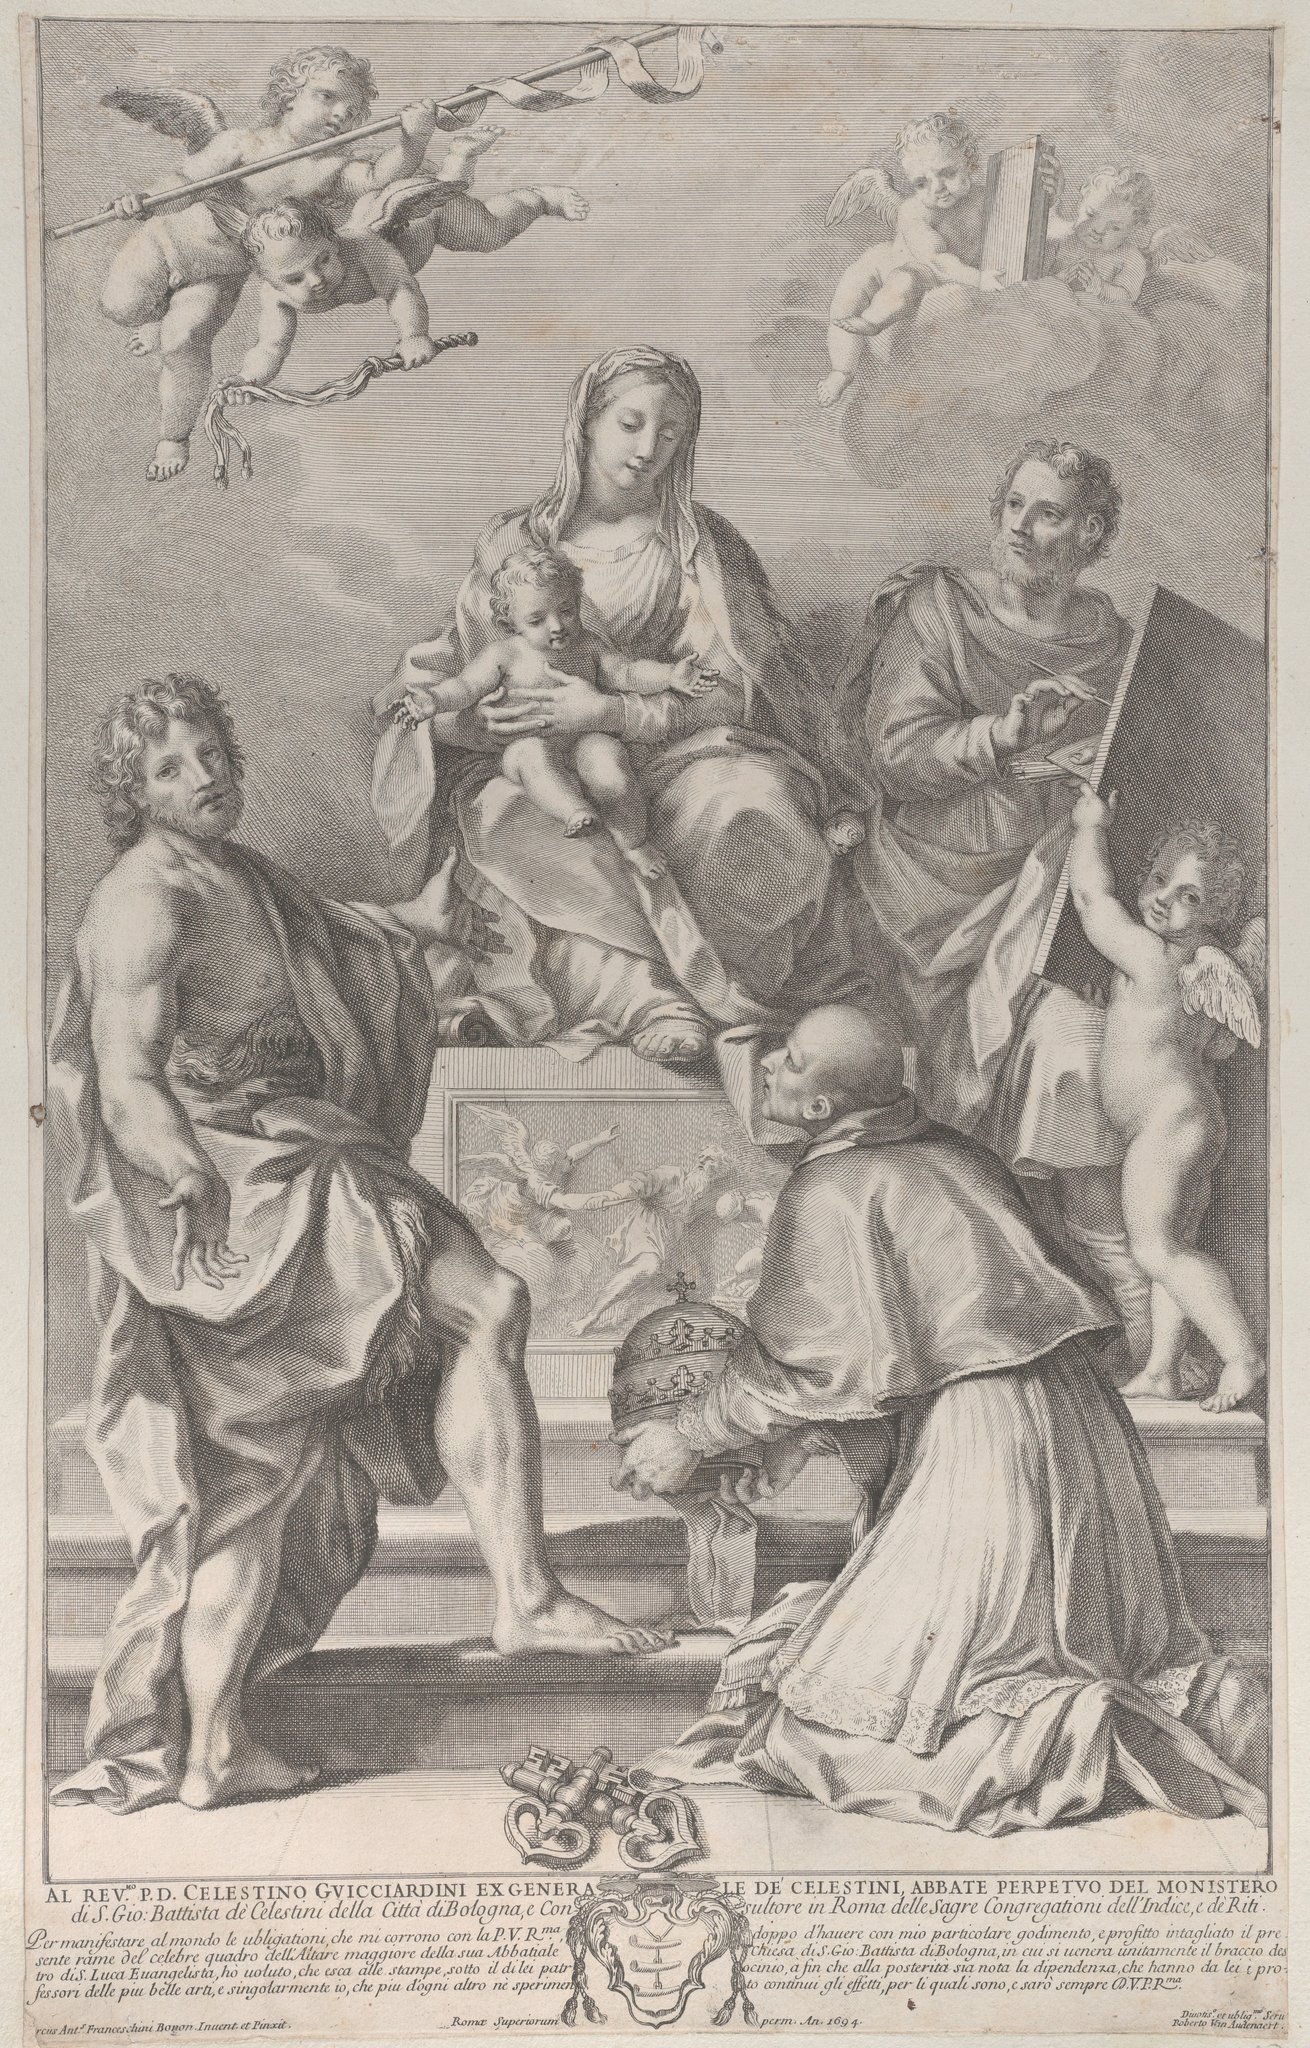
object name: print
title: Madonna and Child at center with Saint John the Baptist, Saint Luke, Pope Peter Celestini, and angels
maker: robert van audenaerde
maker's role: artist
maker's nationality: flemish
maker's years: 1663-1743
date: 1694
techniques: engraving, etching